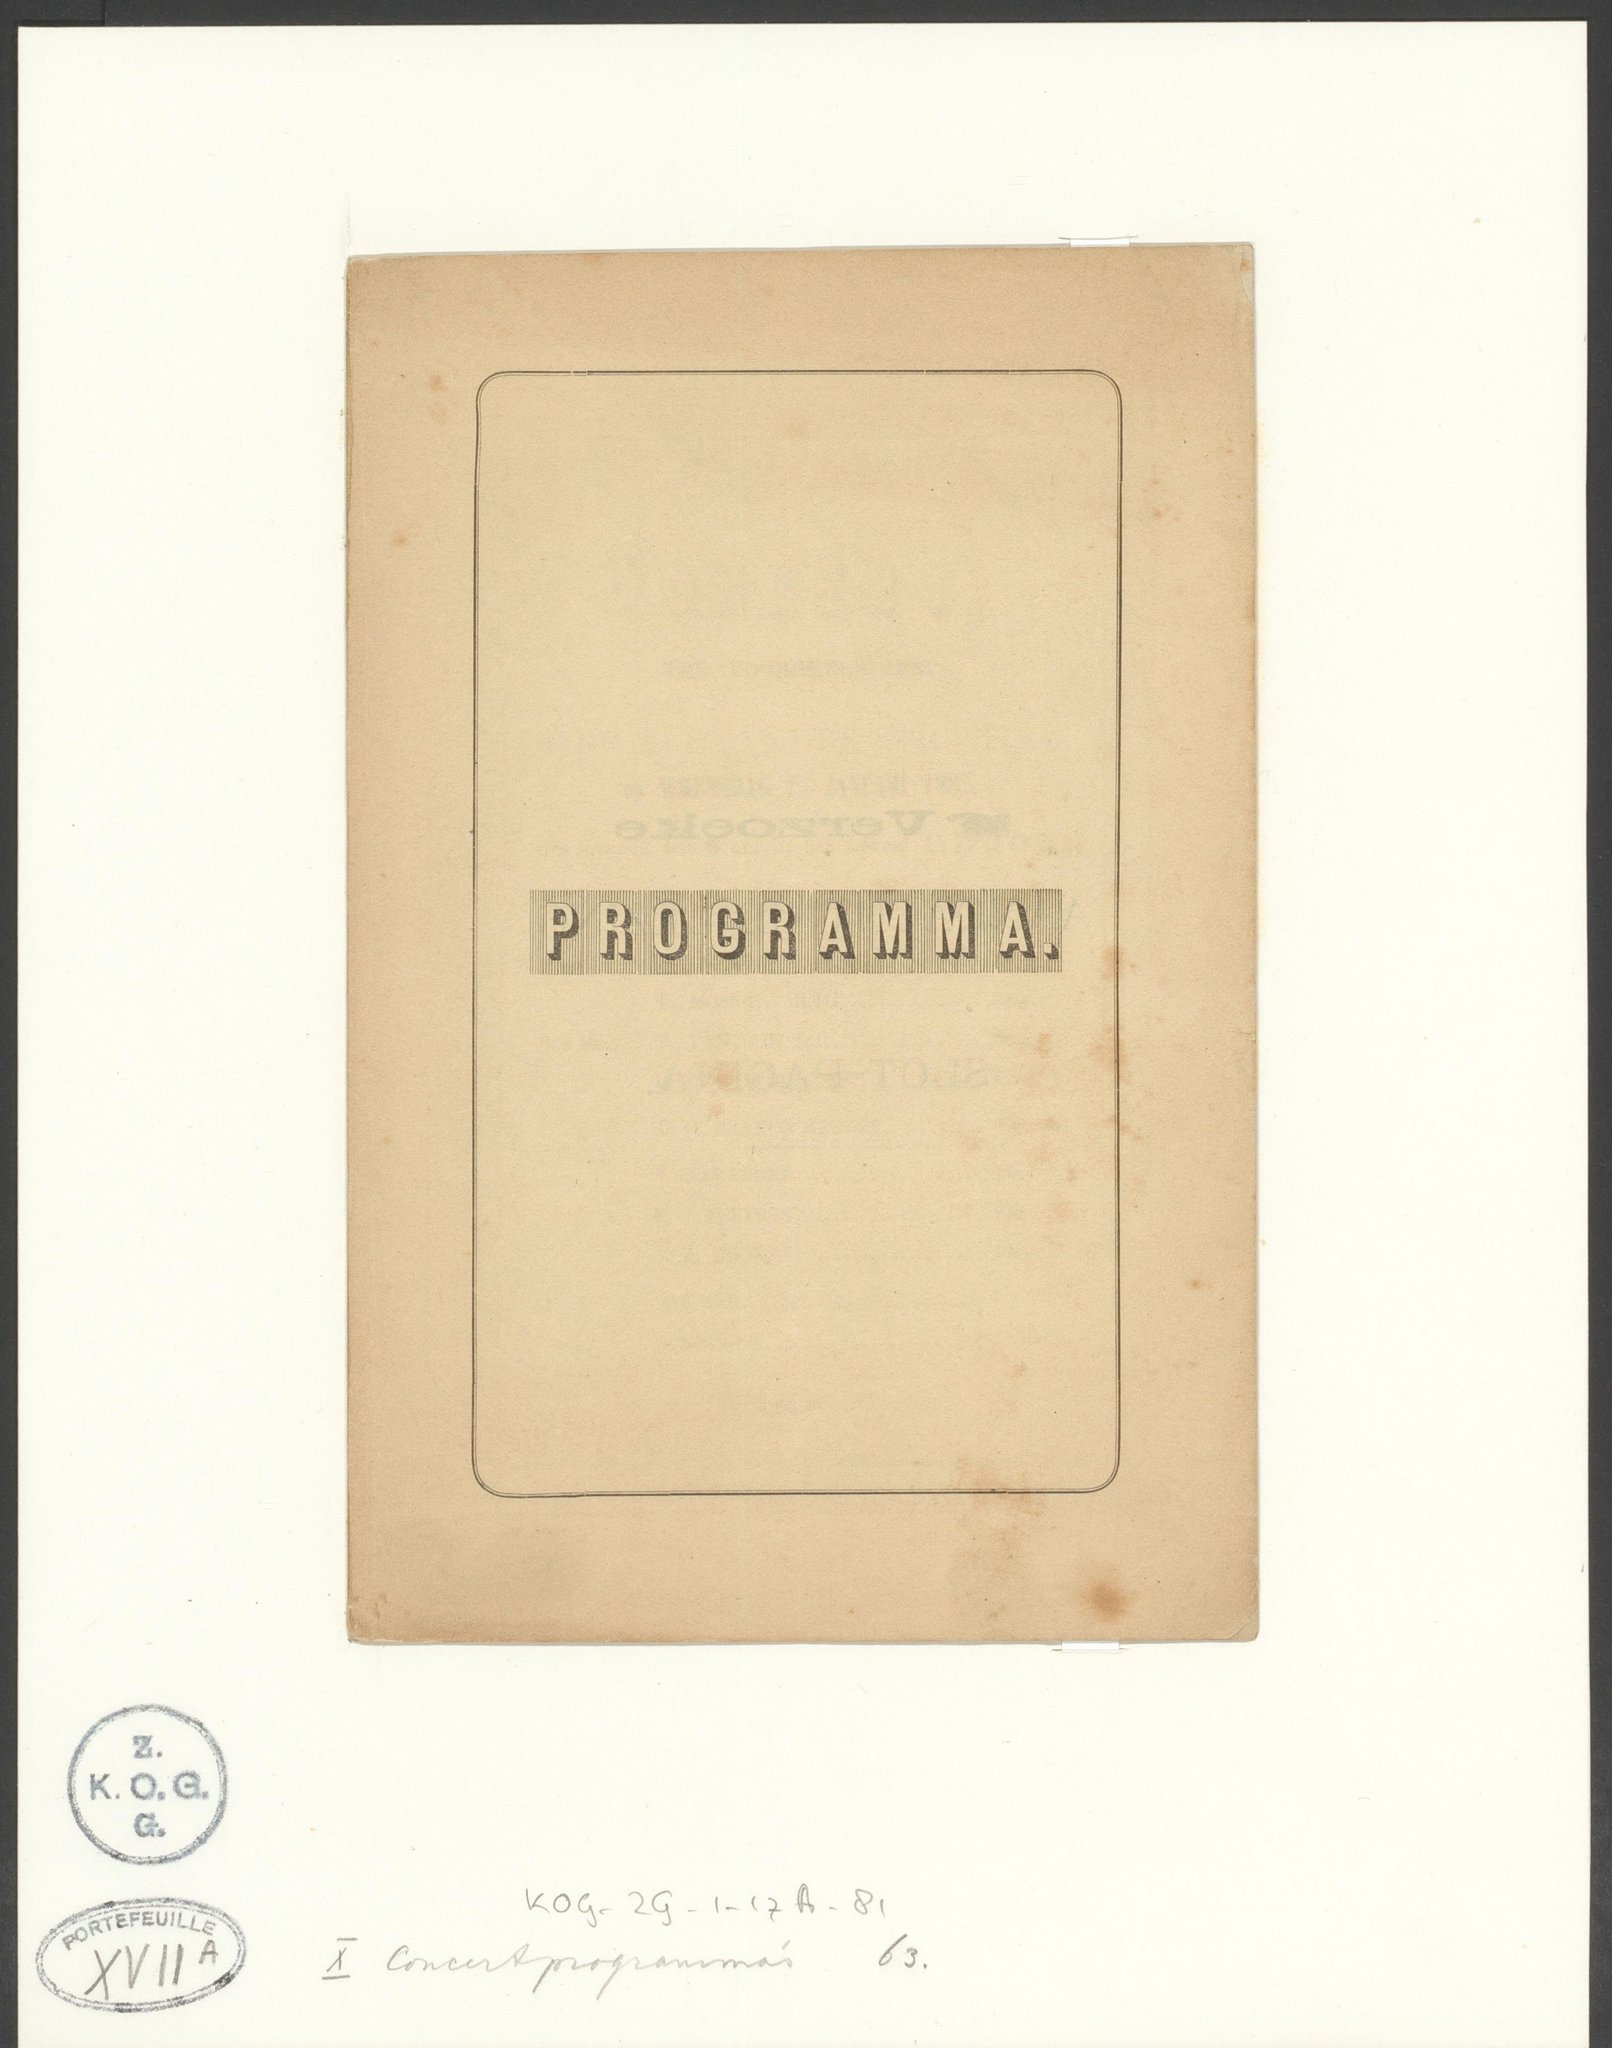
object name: text sheet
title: Programmaboekje voor een concert in Lokaal Odéon op 25 januari 1882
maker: beer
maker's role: printer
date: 1882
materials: paper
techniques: lithograph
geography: amsterdam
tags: listening to music, large group of musicians, orchestra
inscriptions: collector's mark, collector's mark: Lugt 1641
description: Gedrukt programmaboekje voor een concert in 'Lokaal Odéon' te Amsterdam op 25 januari 1882, ten behoeve van de Prins Alexander Stichting te Bennekom. Tien genummerde bladzijden met het programma en de teksten van de liederen. Onderwerpsrubrieken binnen de Atlas Zeden en Gewoonten: Muziek en muziekinstrumenten: Varia.